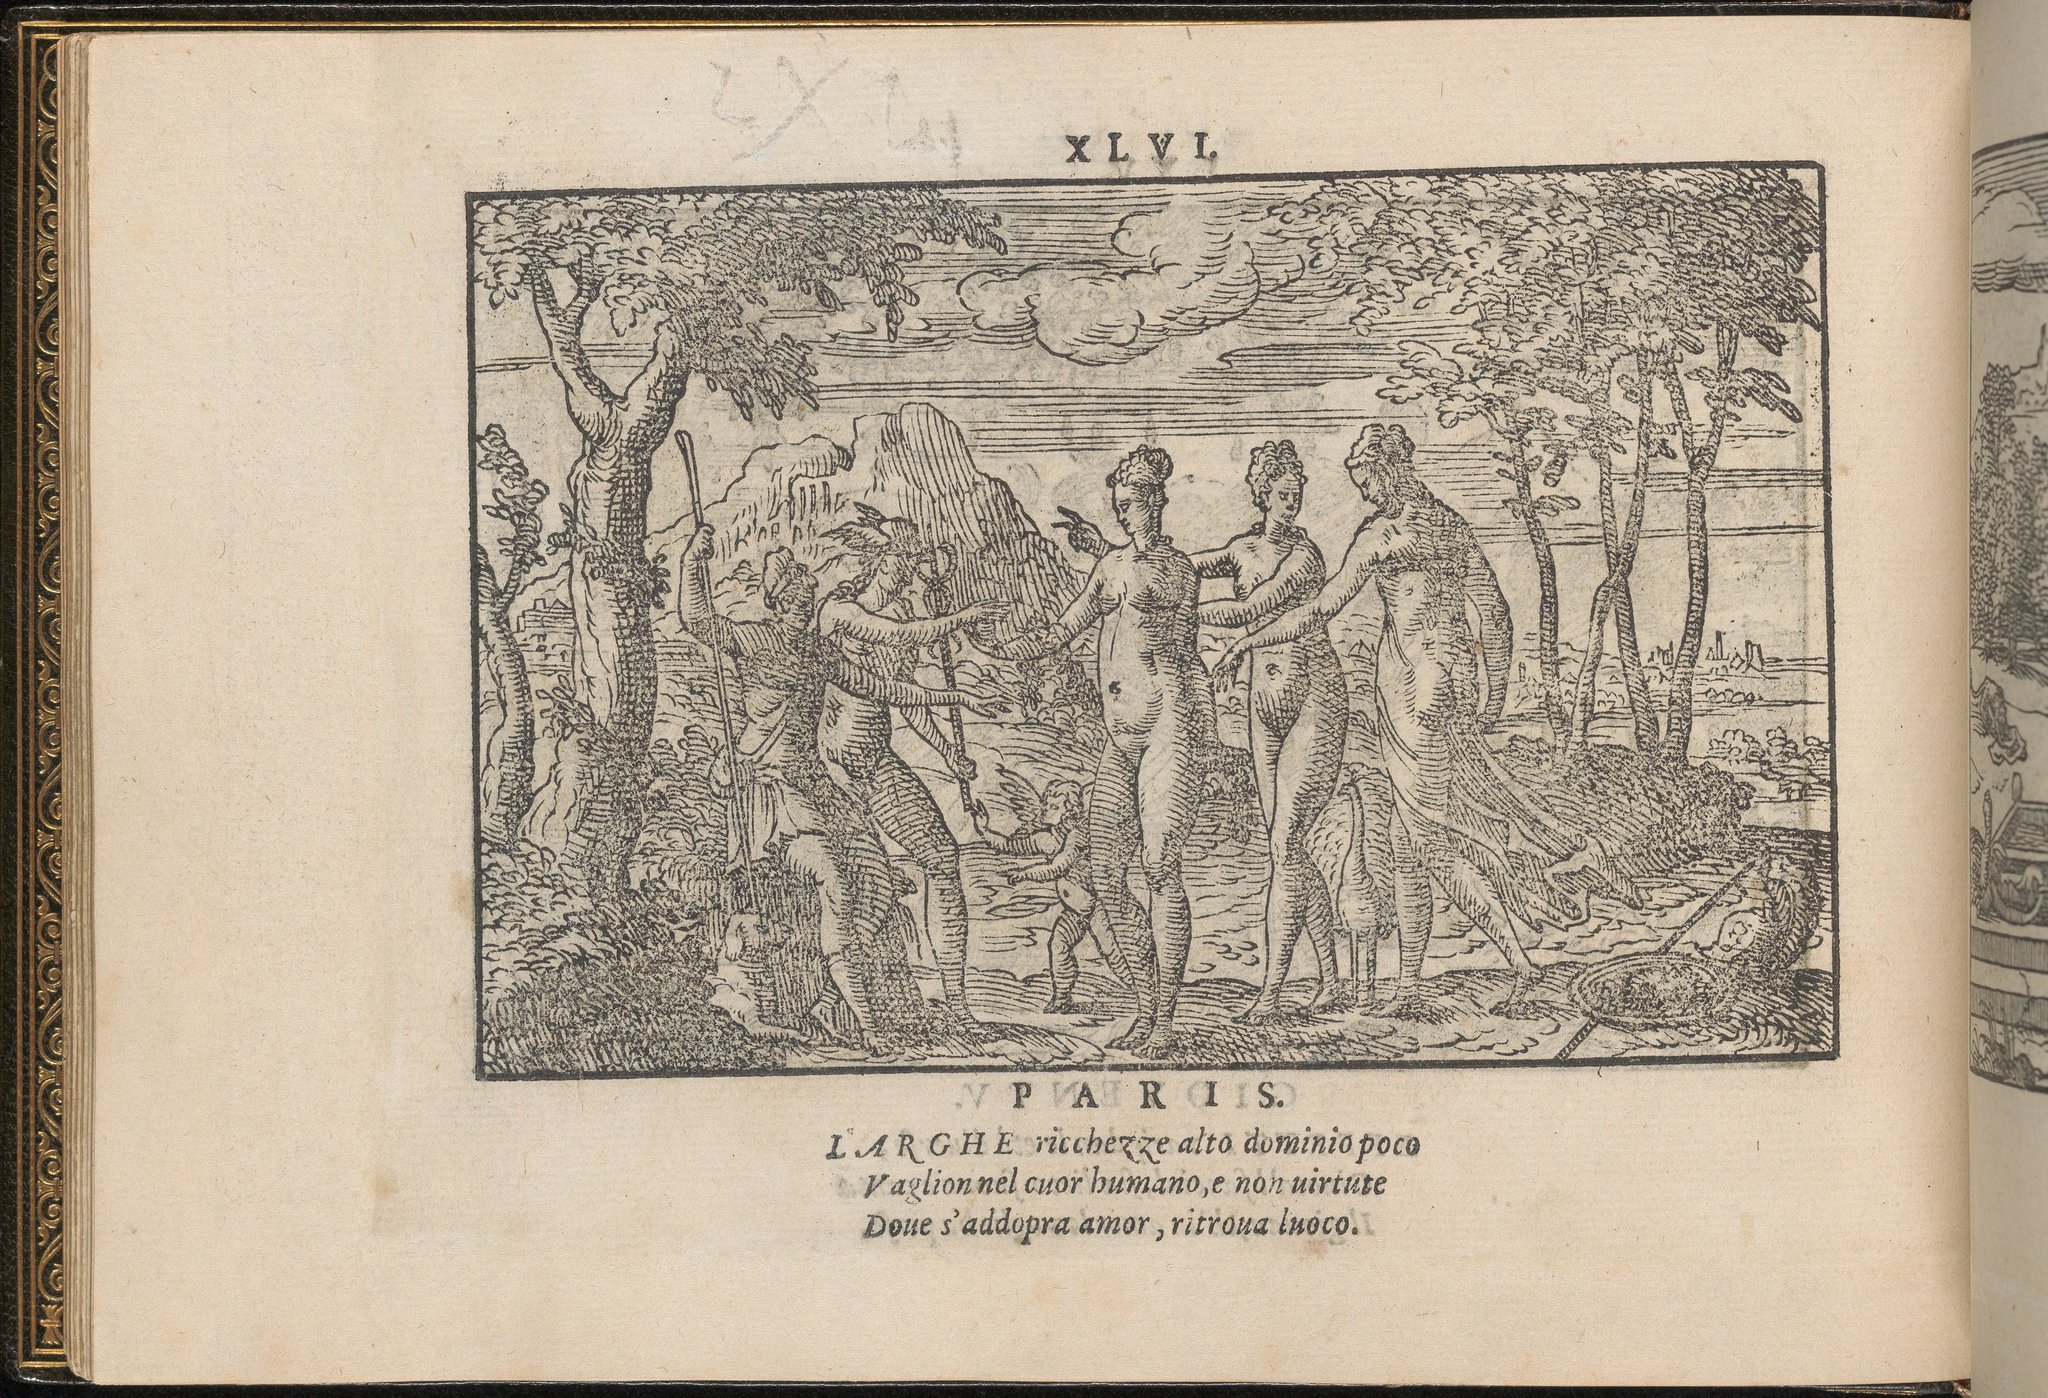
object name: book print ornament architecture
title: La Vera Perfettione del Disegno di varie sorti di recami, page 23 (verso)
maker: giovanni ostaus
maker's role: publisher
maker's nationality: italian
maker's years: 1507-1607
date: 1567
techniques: woodcut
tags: female nudes